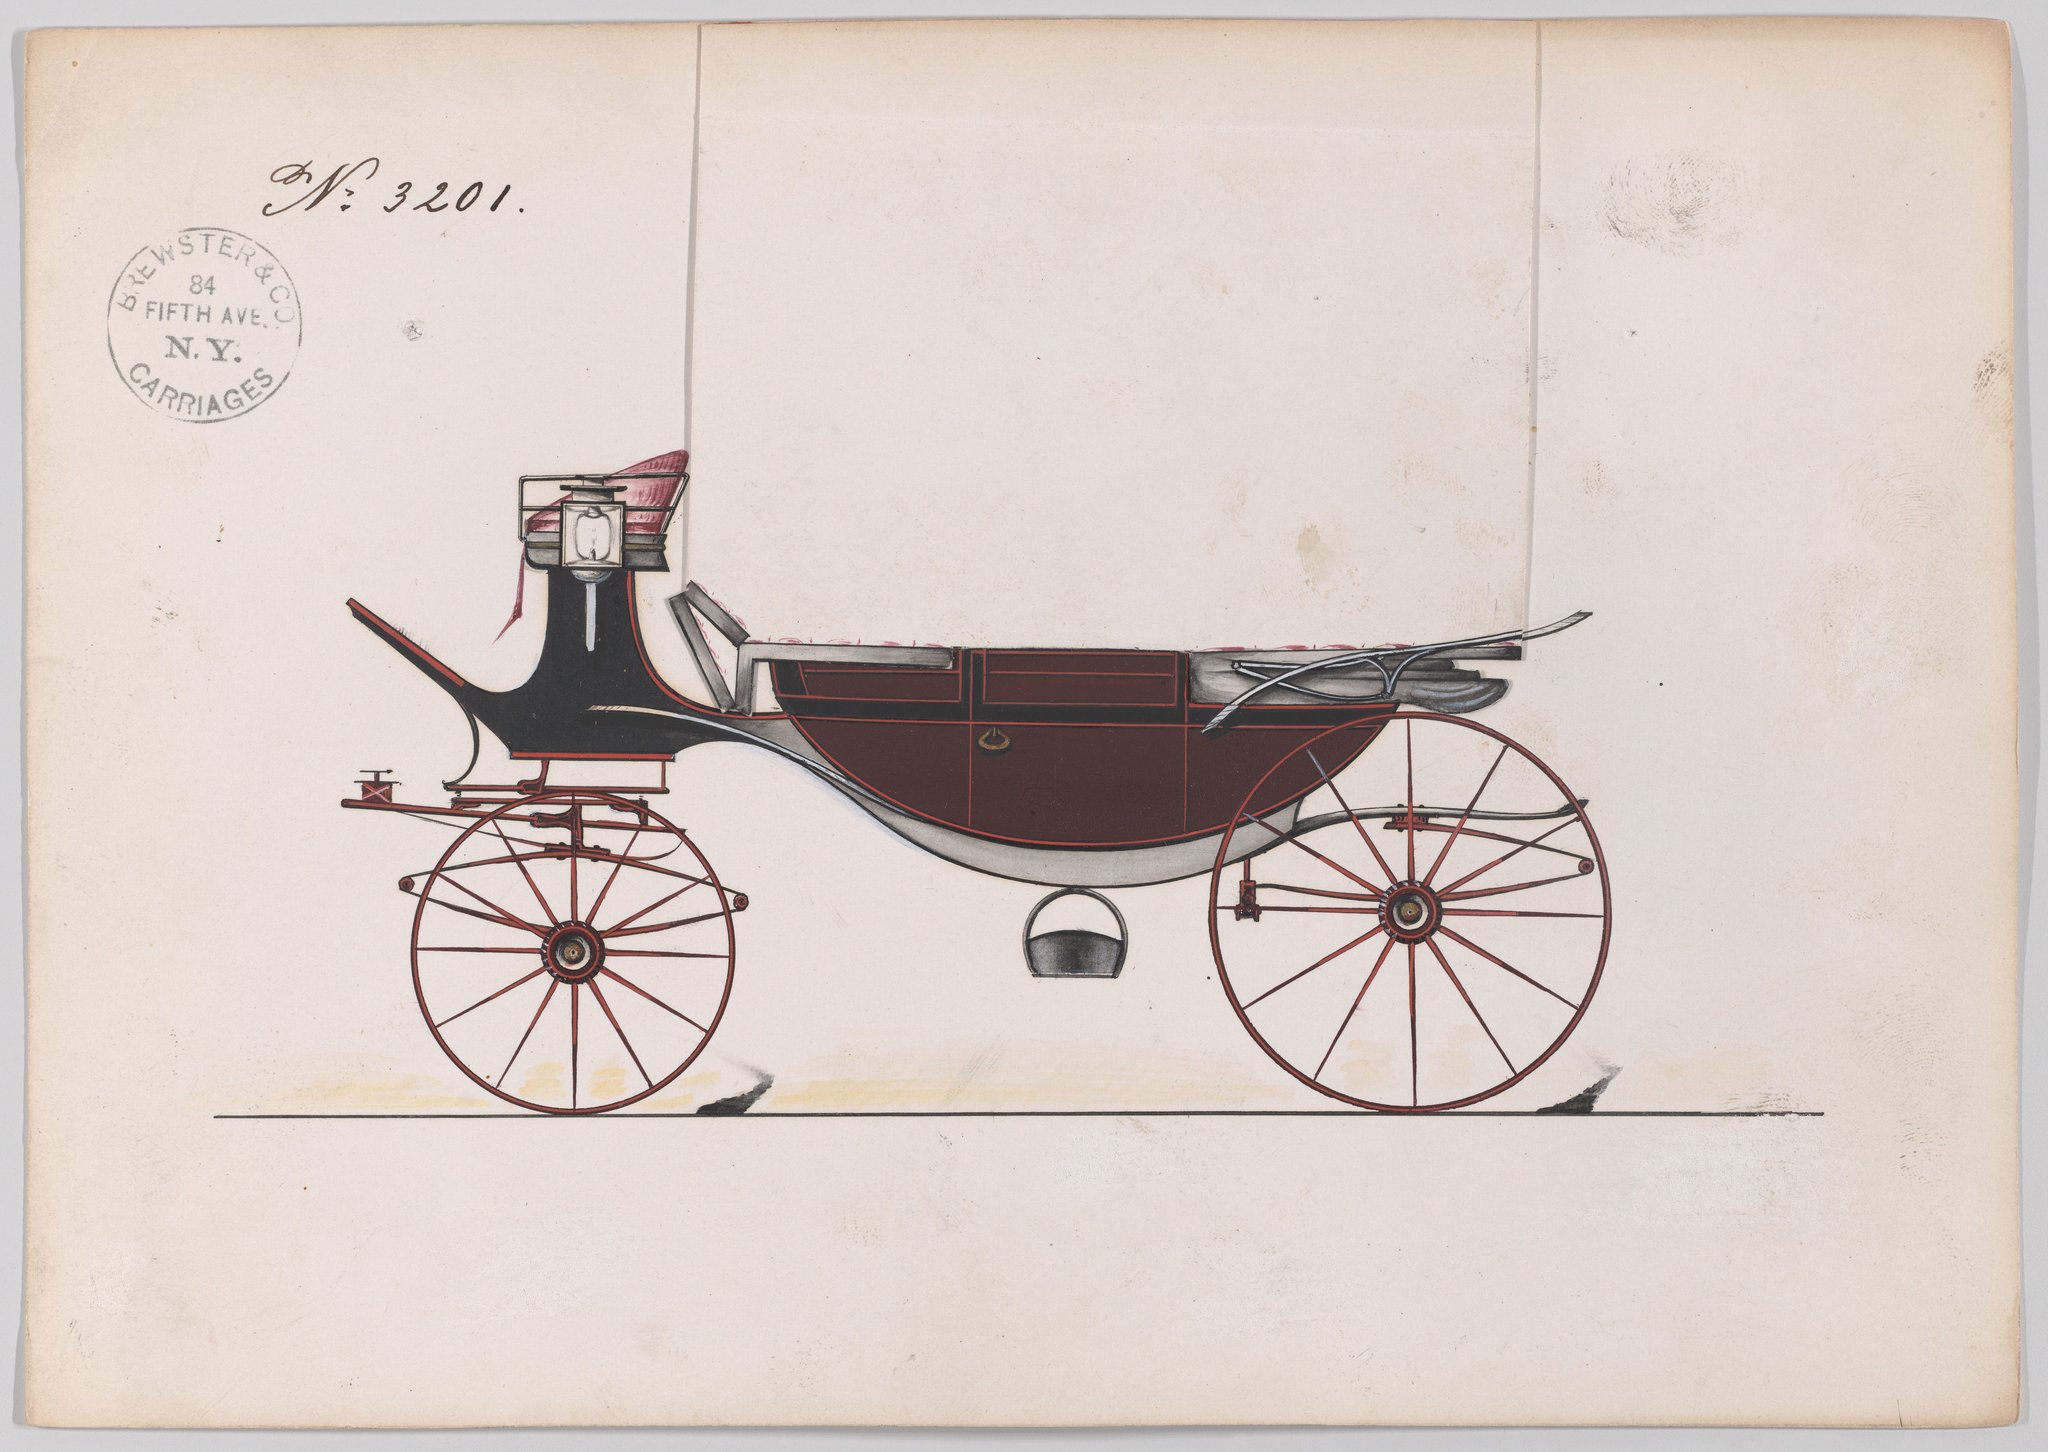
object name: drawing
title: Design for Landau, No. 3201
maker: brewster & co.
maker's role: manufacturer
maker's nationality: american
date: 1876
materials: gouache, ink, watercolor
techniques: pen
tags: carriages